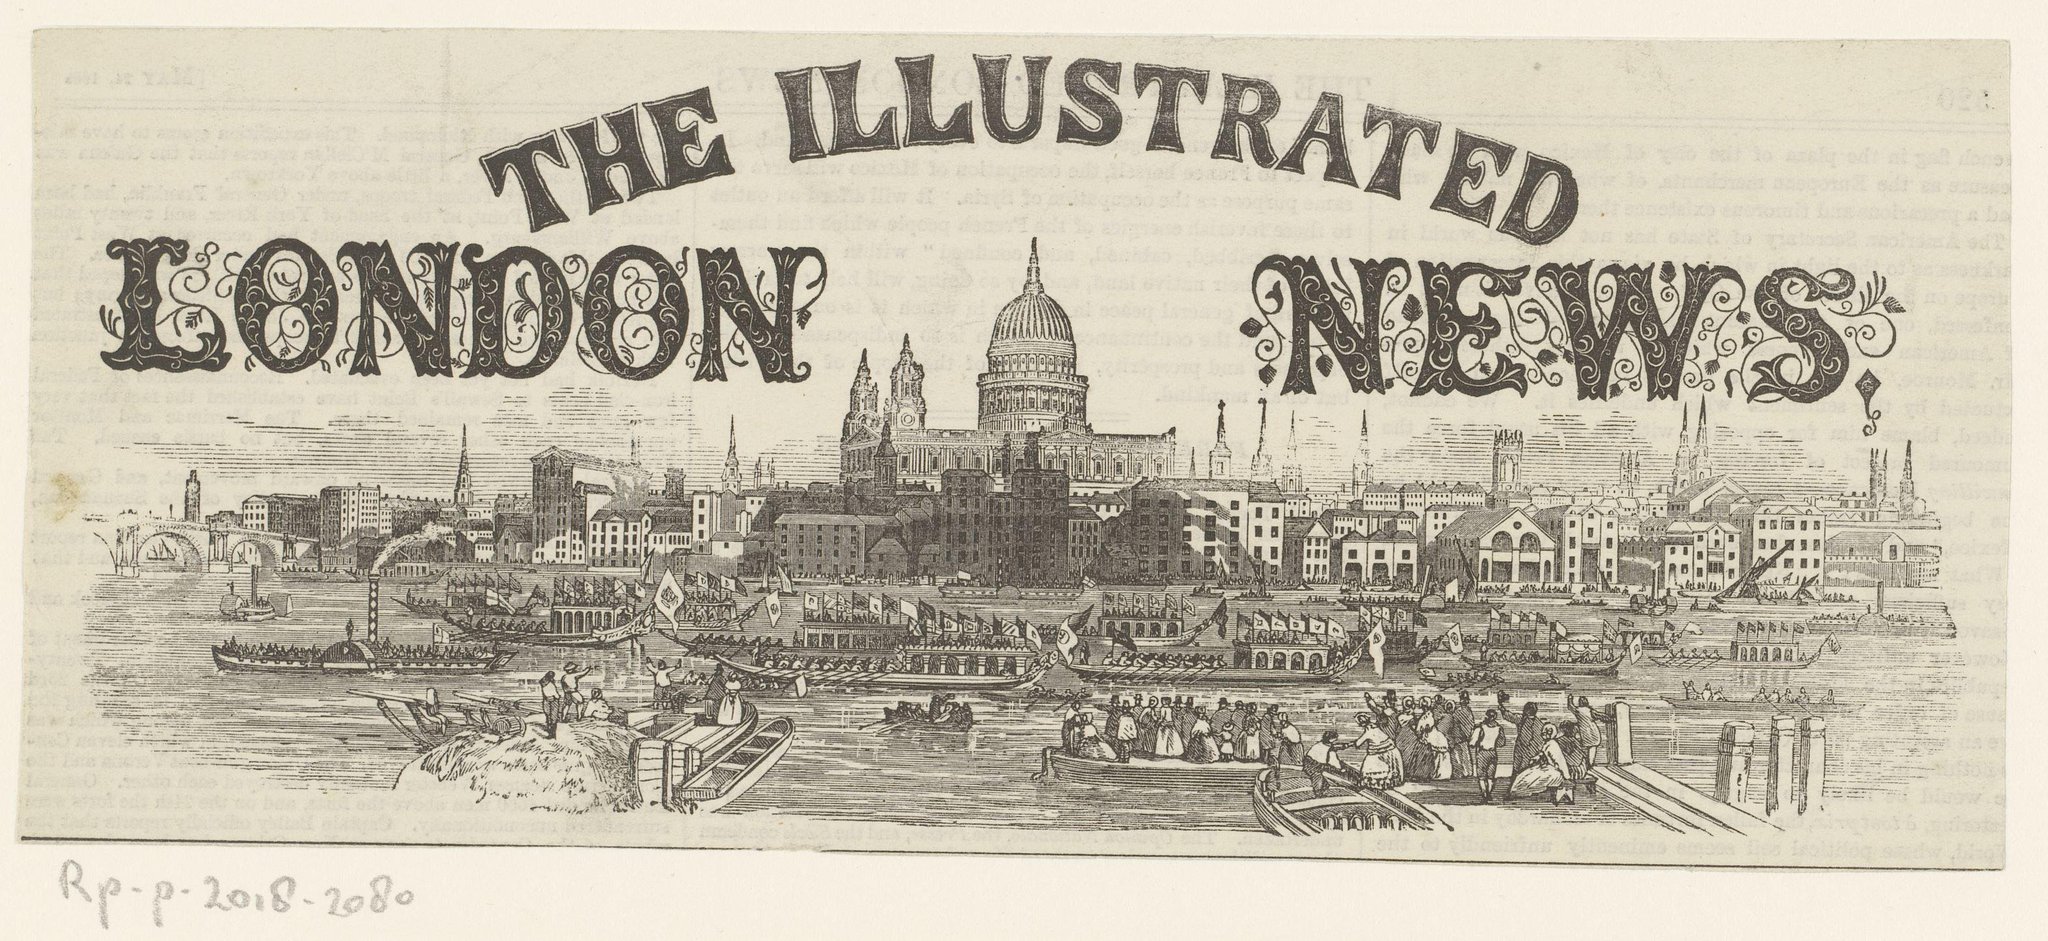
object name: print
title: Kop van 'The Illustrated London News', 1862, met een gezicht op Londen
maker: Anonymous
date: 1862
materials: paper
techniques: letterpress printing, engraving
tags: prospect of city, town panorama, silhouette of city, london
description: Prent gebruikt in: The Illustrated London News, 24 mei 1862.